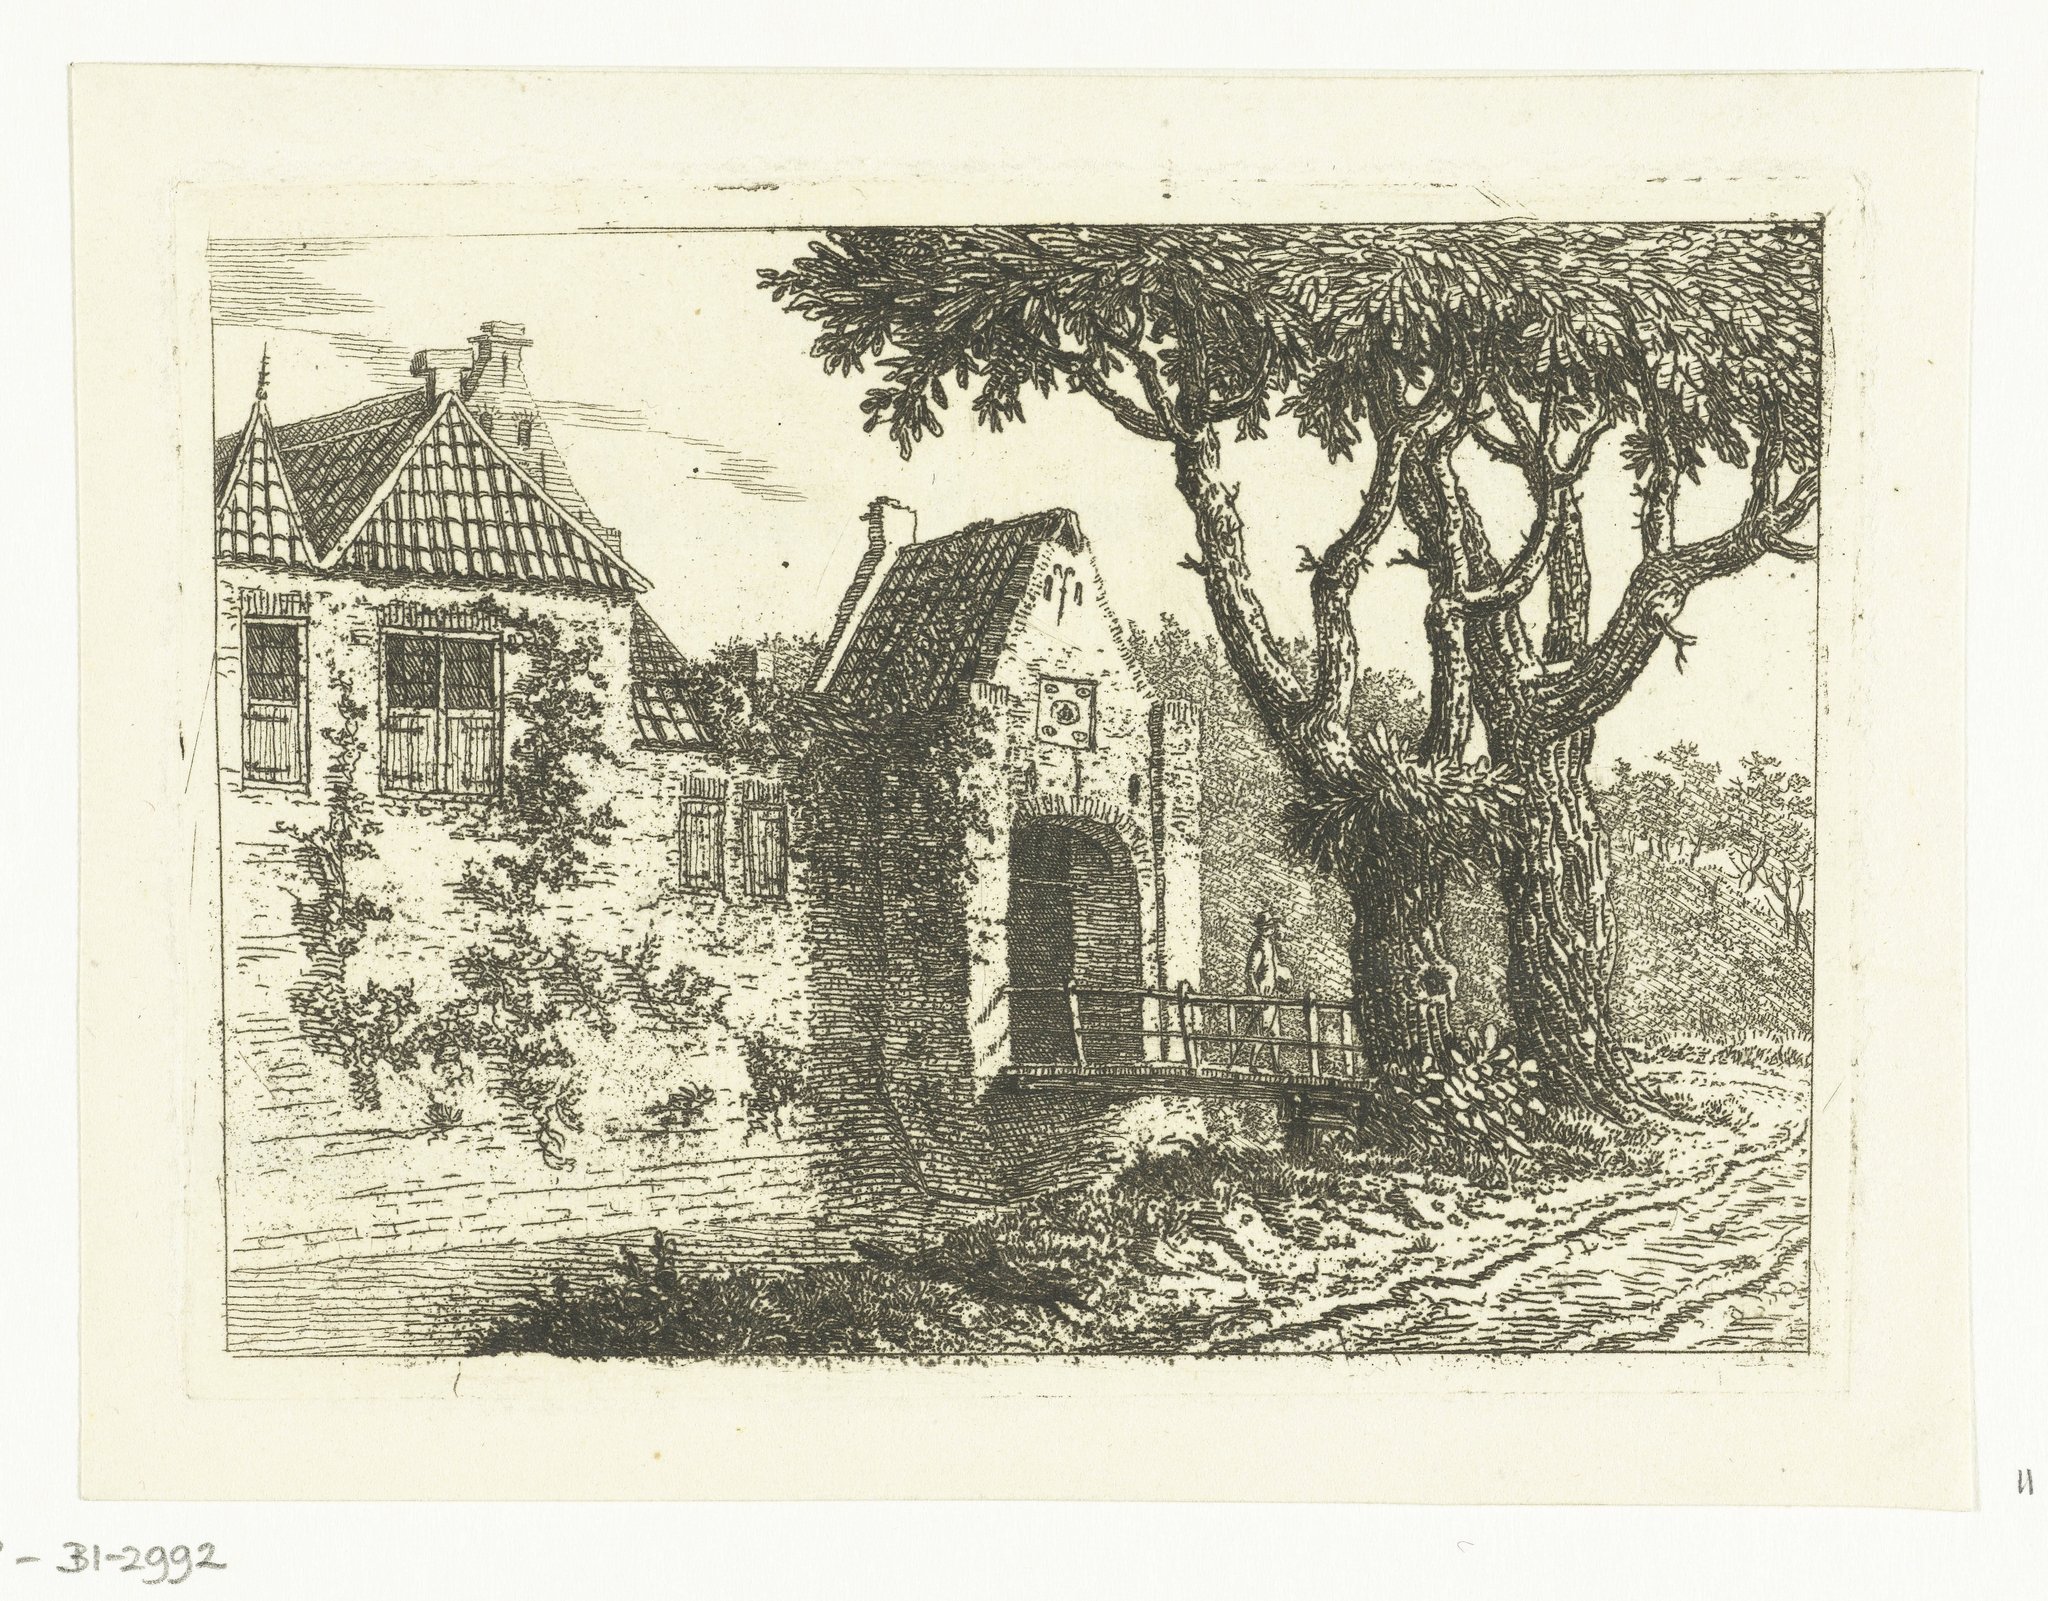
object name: print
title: Kasteel Voorst bij Zwolle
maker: anthonie van den bos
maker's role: draughtsman, print maker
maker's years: 1763-1838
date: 1778-1838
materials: paper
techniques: etching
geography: netherlands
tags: castle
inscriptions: collector's mark: Lugt 2228